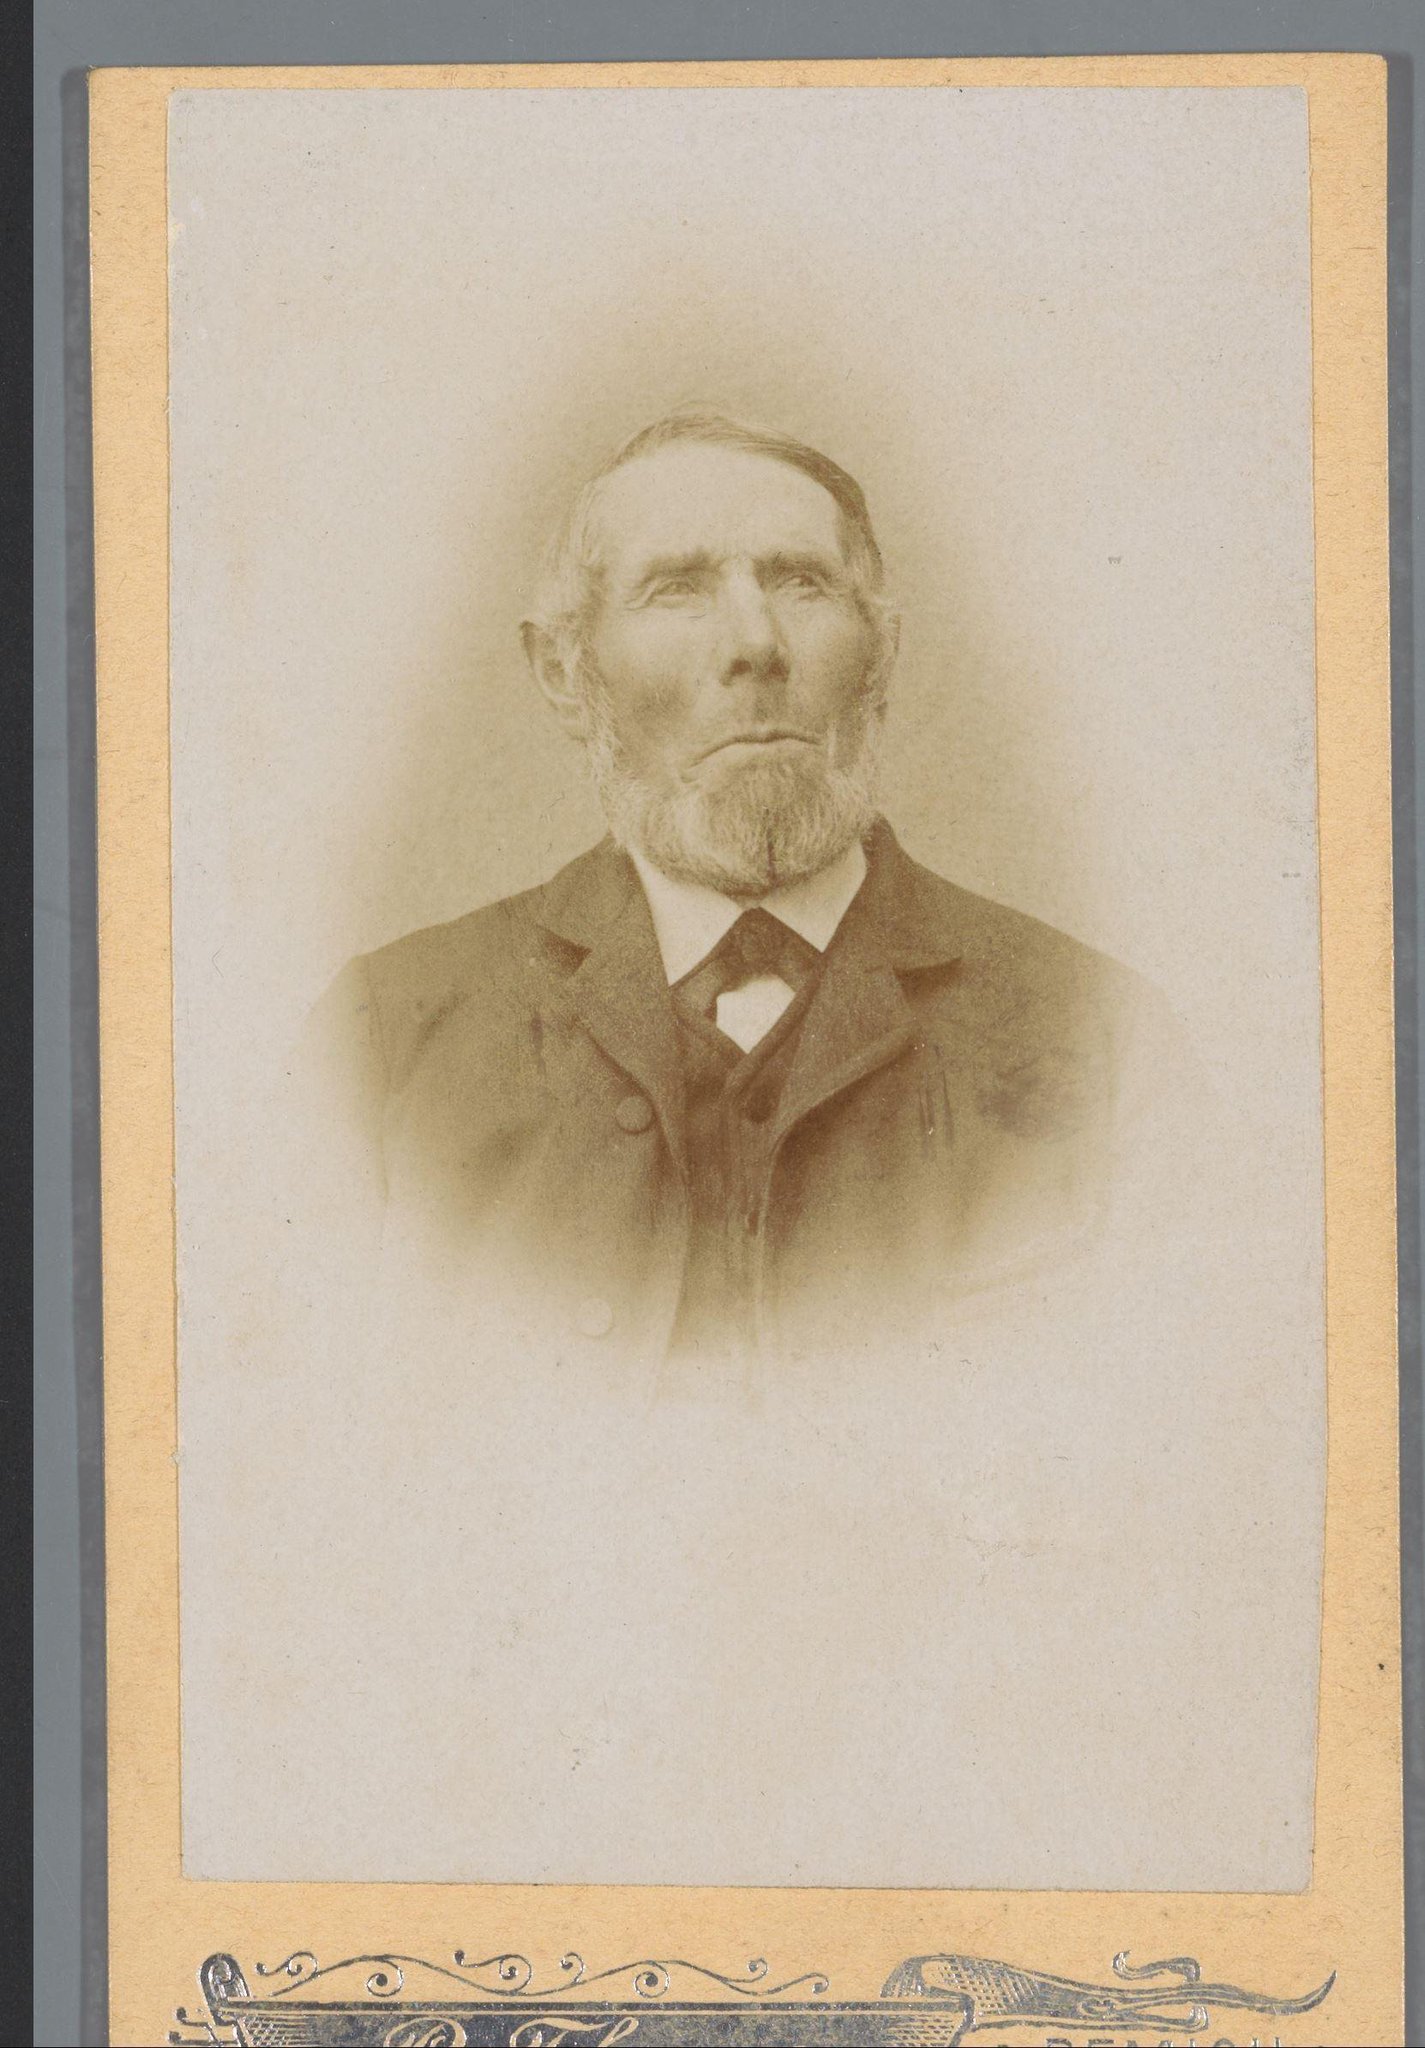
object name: photograph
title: Portret van een onbekende oude man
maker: pierre thorn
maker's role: fotograaf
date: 1900-1914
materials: paper, cardboard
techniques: collodion silver print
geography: remich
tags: adult man, anonymous historical person portrayed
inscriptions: address: ‘REMICH/ G. D. LUXEMBOURG.’